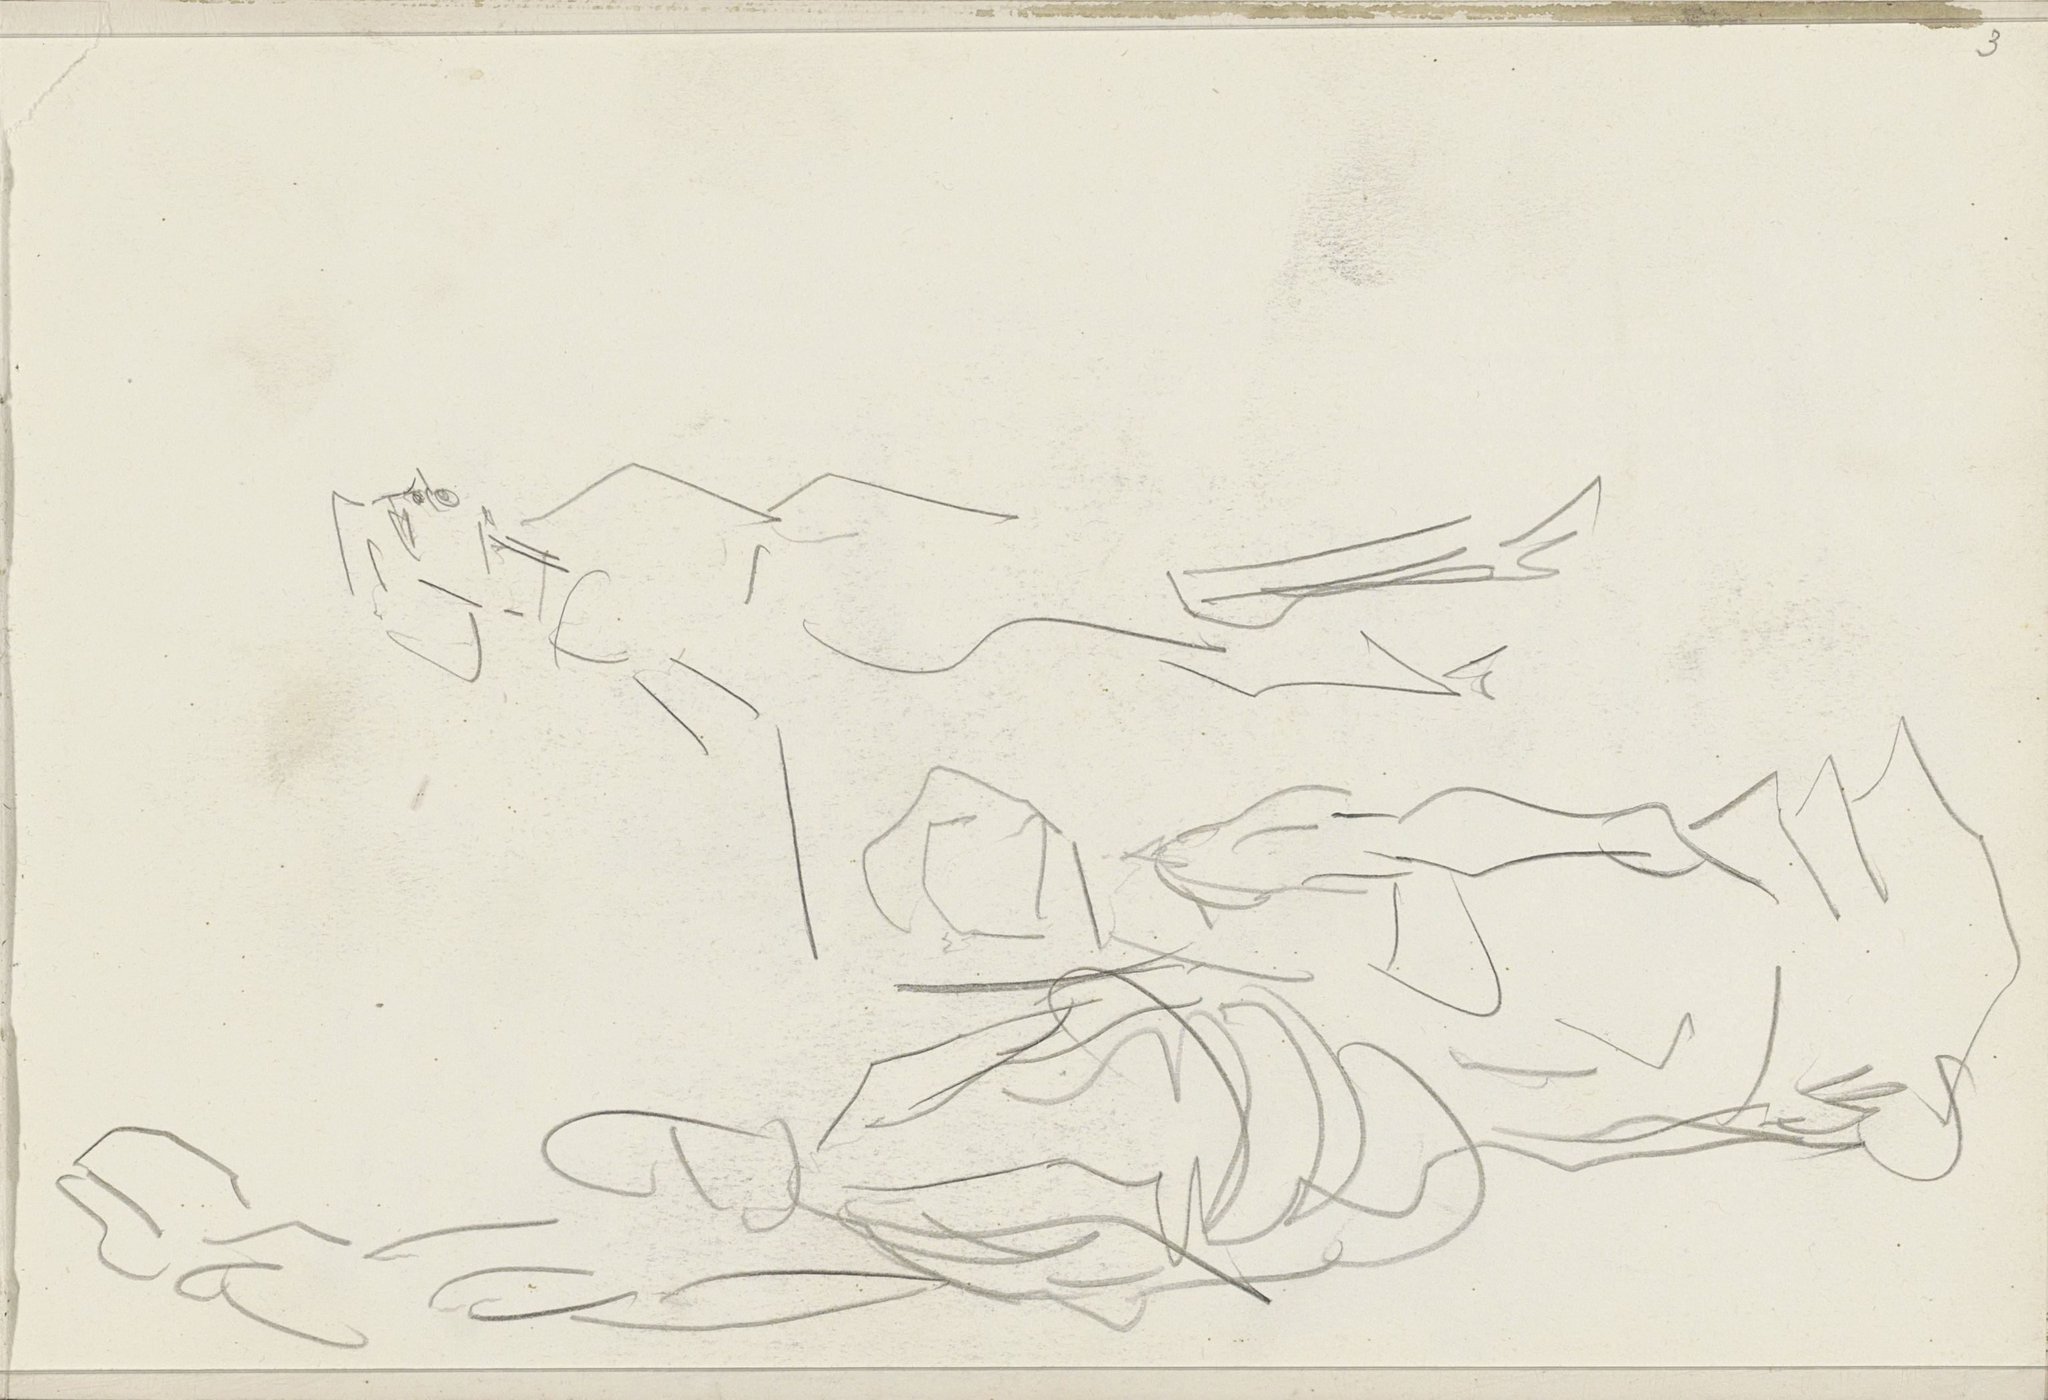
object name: sketchbook leaf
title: Studieblad met vrouwen, mogelijk op het toneel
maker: isaac israels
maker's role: draughtsman, painter, print maker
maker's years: 1865-1934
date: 1875-1934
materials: paper, pencil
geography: the hague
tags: adult woman (+ standing), the stage and its equipment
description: Blad 3 recto uit schetsboek XXVIII met 17 bladen.